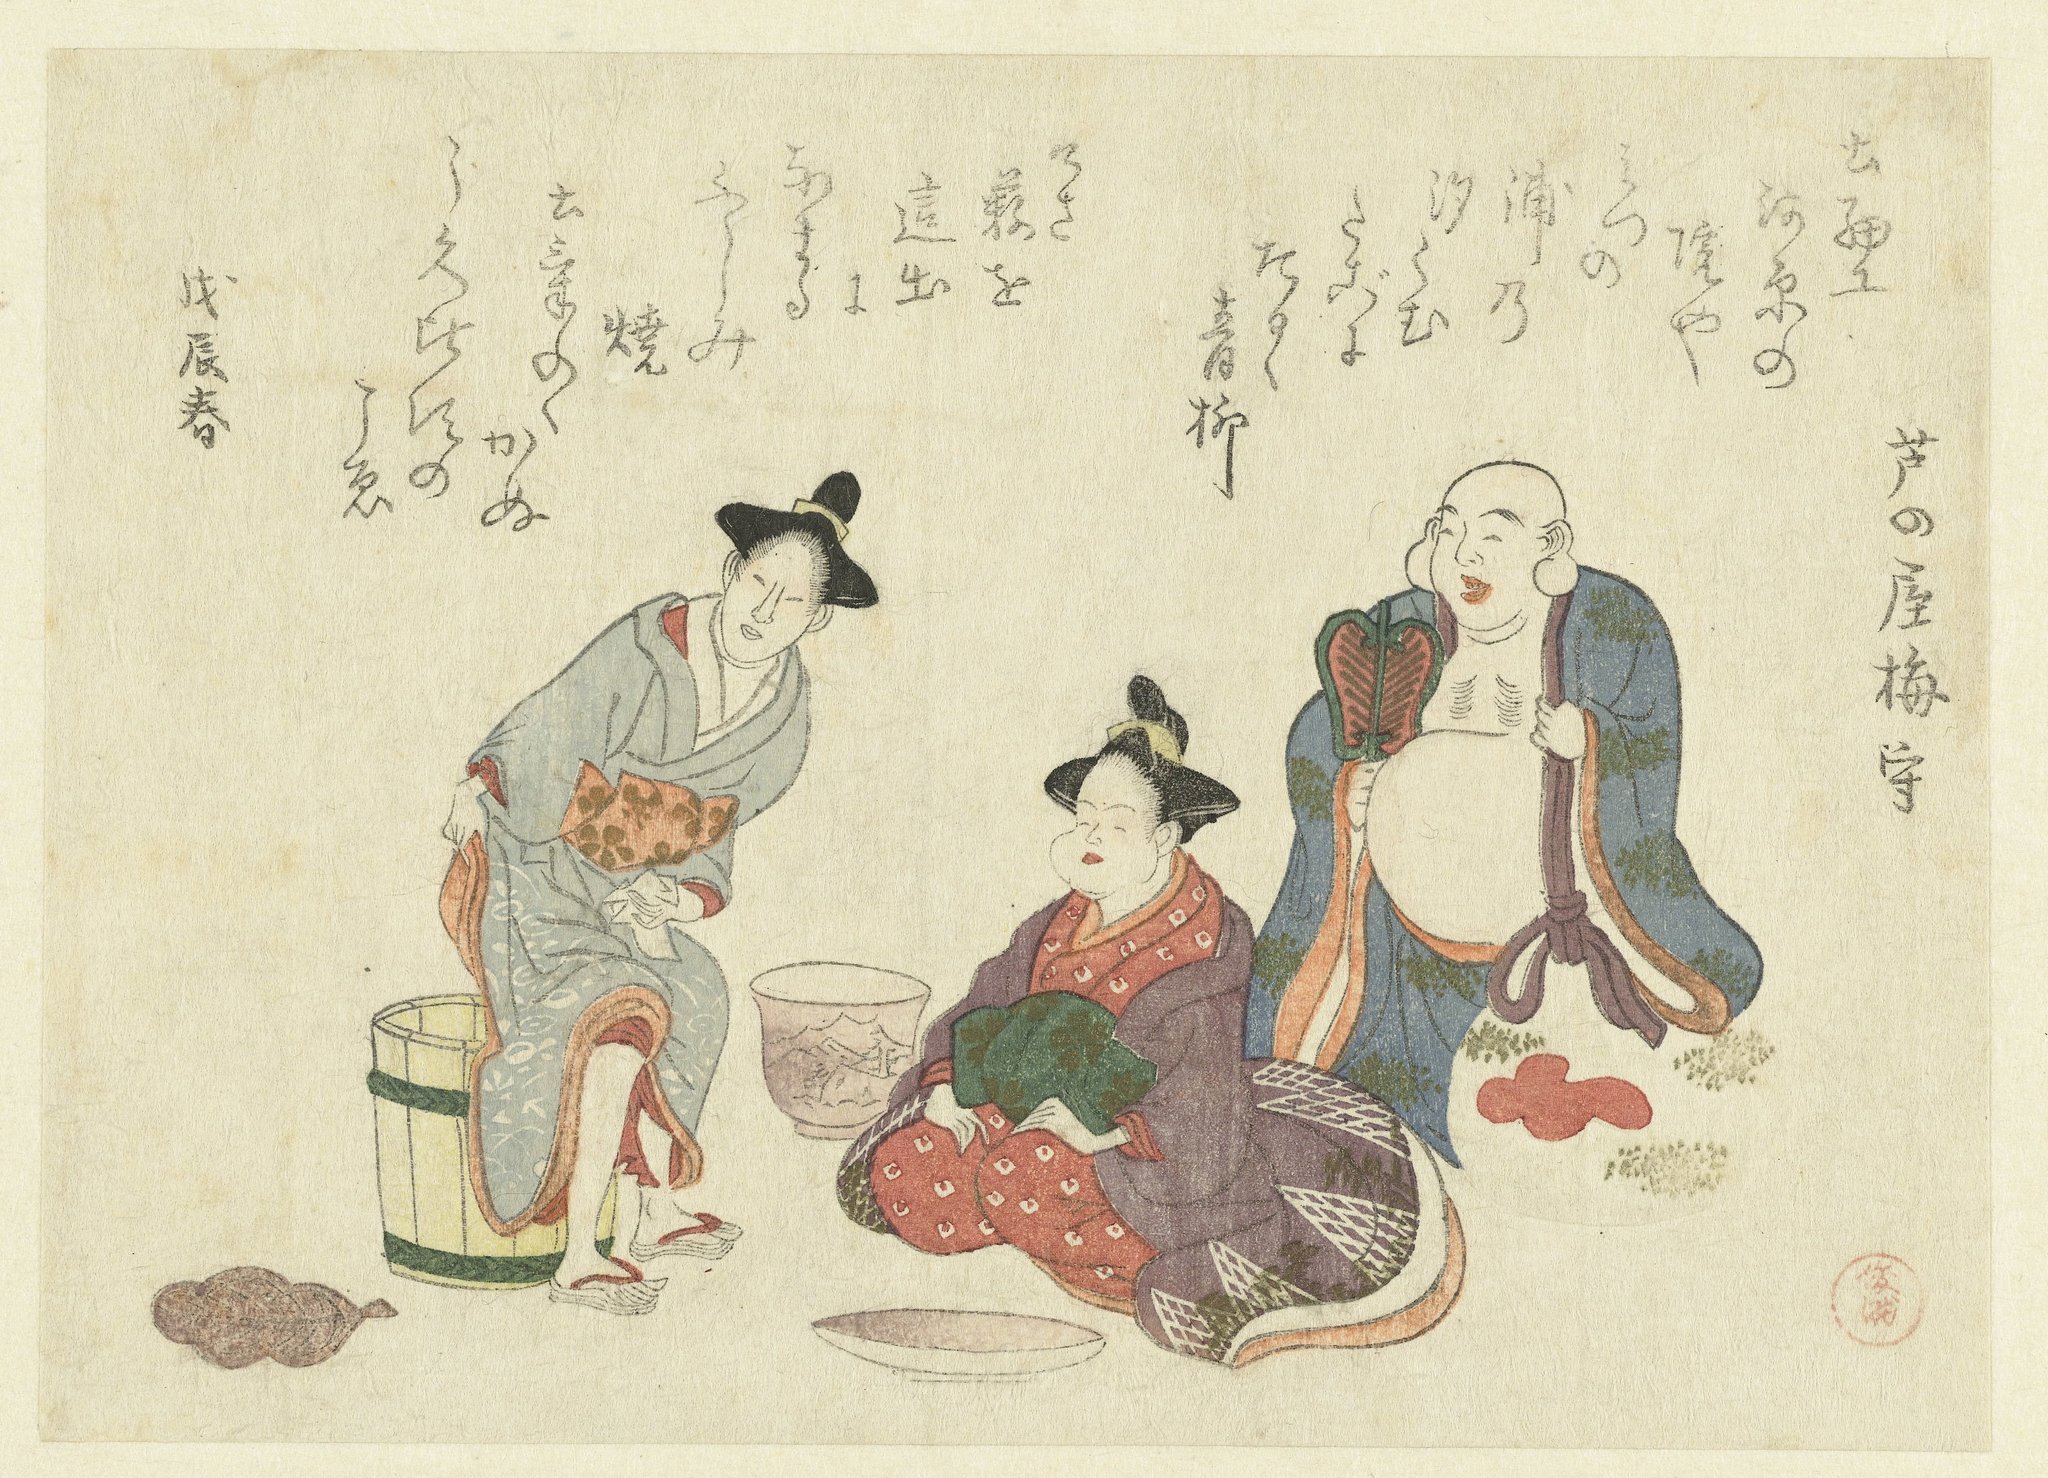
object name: print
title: Woman Using the Toilet and Two Popular Gods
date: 1808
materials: paper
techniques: blind stamped, woodcut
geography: japan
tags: wooden container: barrel, cask, bucket, piece of sculpture, reproduction of a piece of sculpture, defecation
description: Een vrouw met toiletpapier in haar hand doet haar behoefte in een houten emmer. De geluksgoden Hotei, met waaier en buidel met schatten, en Okame kijken toe. Het theekopje op de achtergrond geeft aan dat hier geen personen zijn afgebeeld, maar kleine beeldjes. Dit wordt ook duidelijk uit de twee gedichten verwijzend naar keramieke komische beeldjes uit Fushimi, een plek ten zuiden van Kioto.